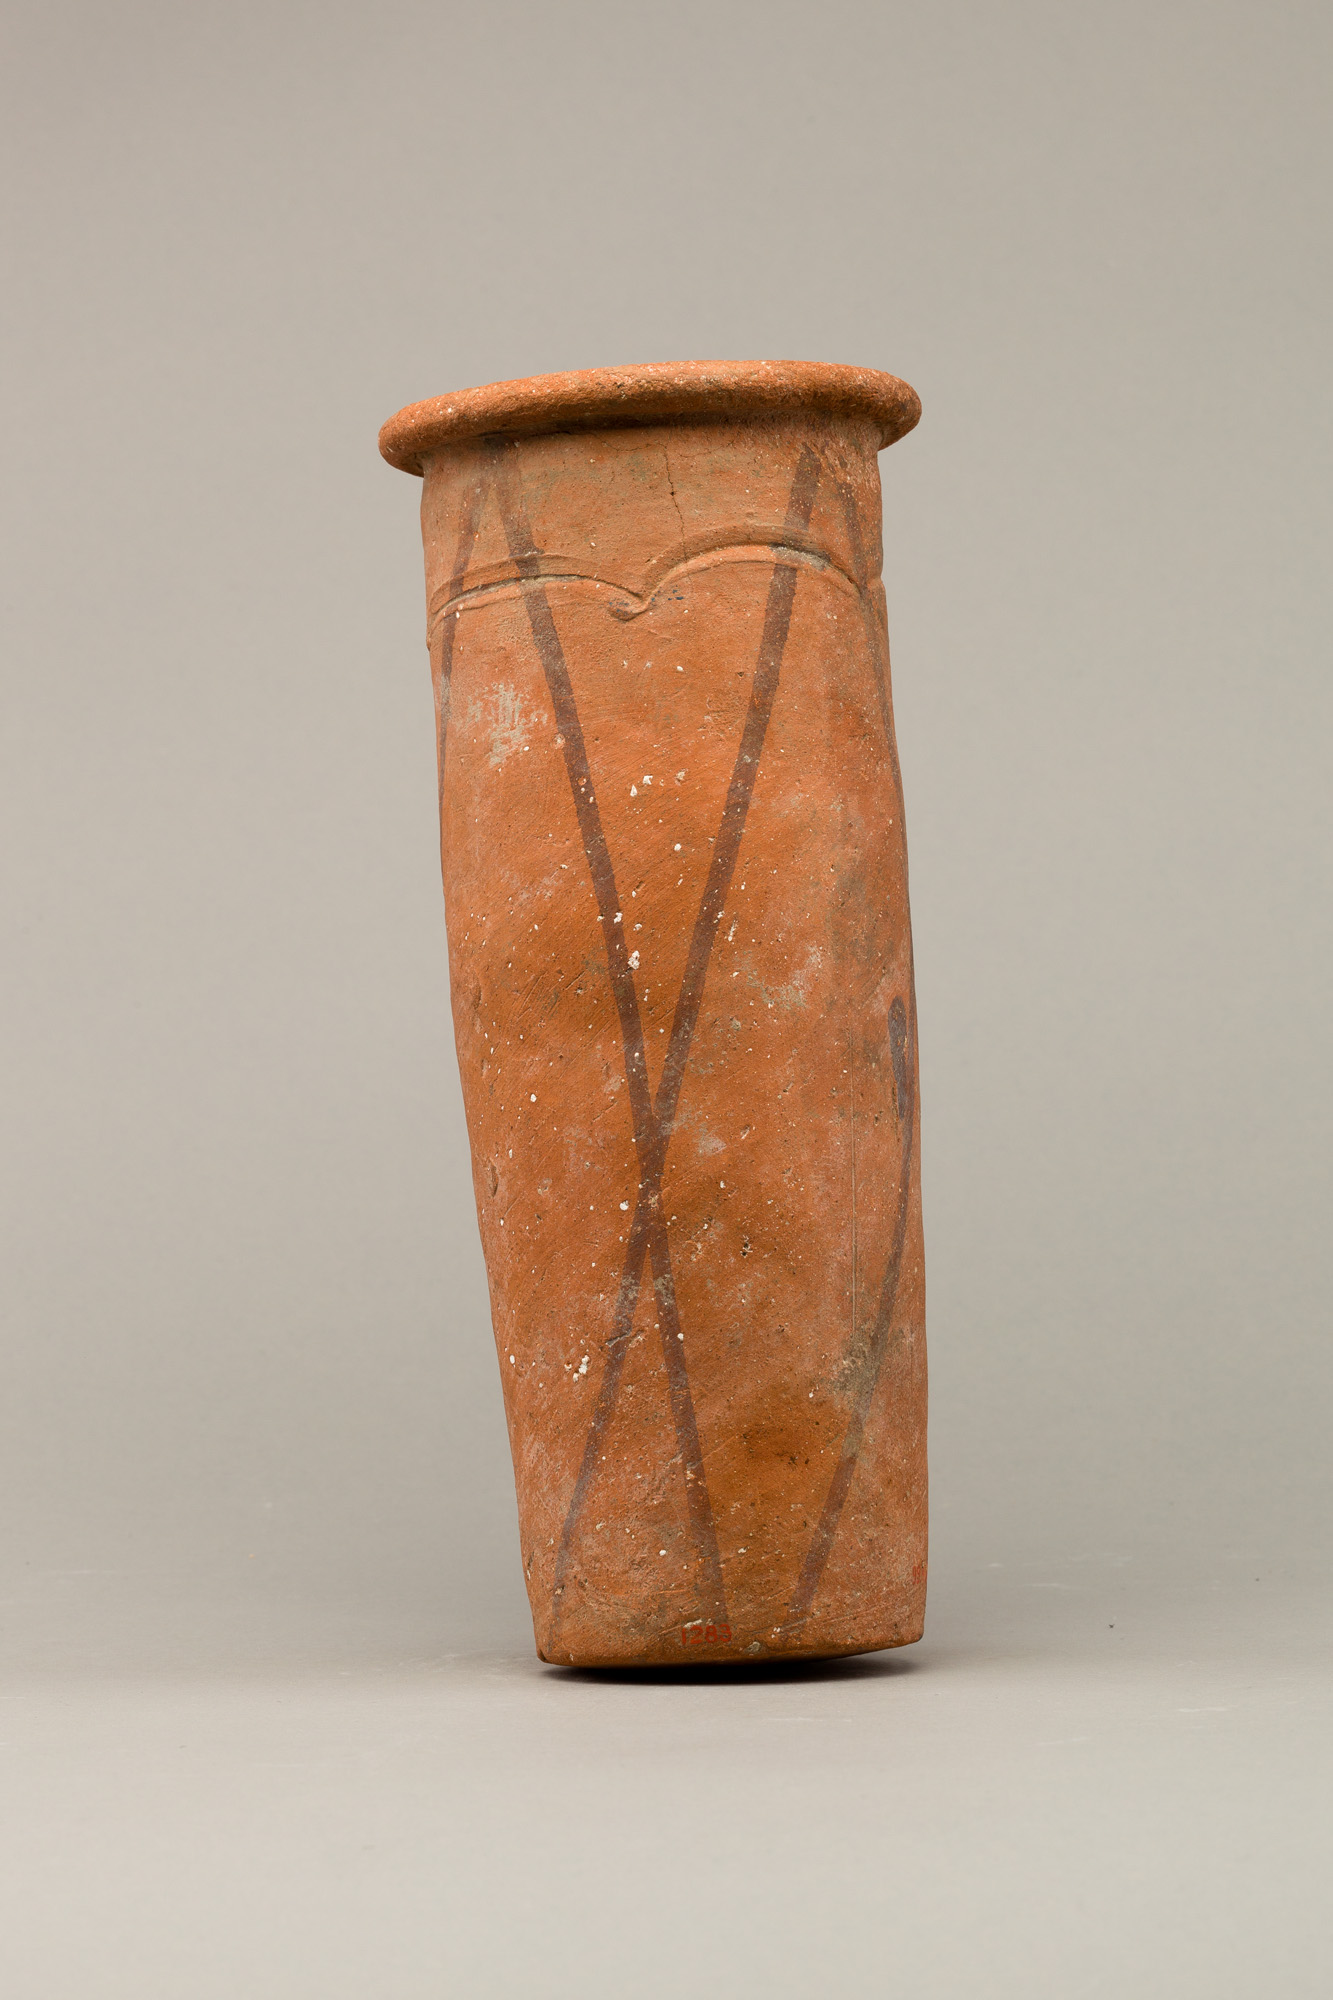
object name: jar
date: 3850-2960 BCE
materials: pottery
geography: egypt